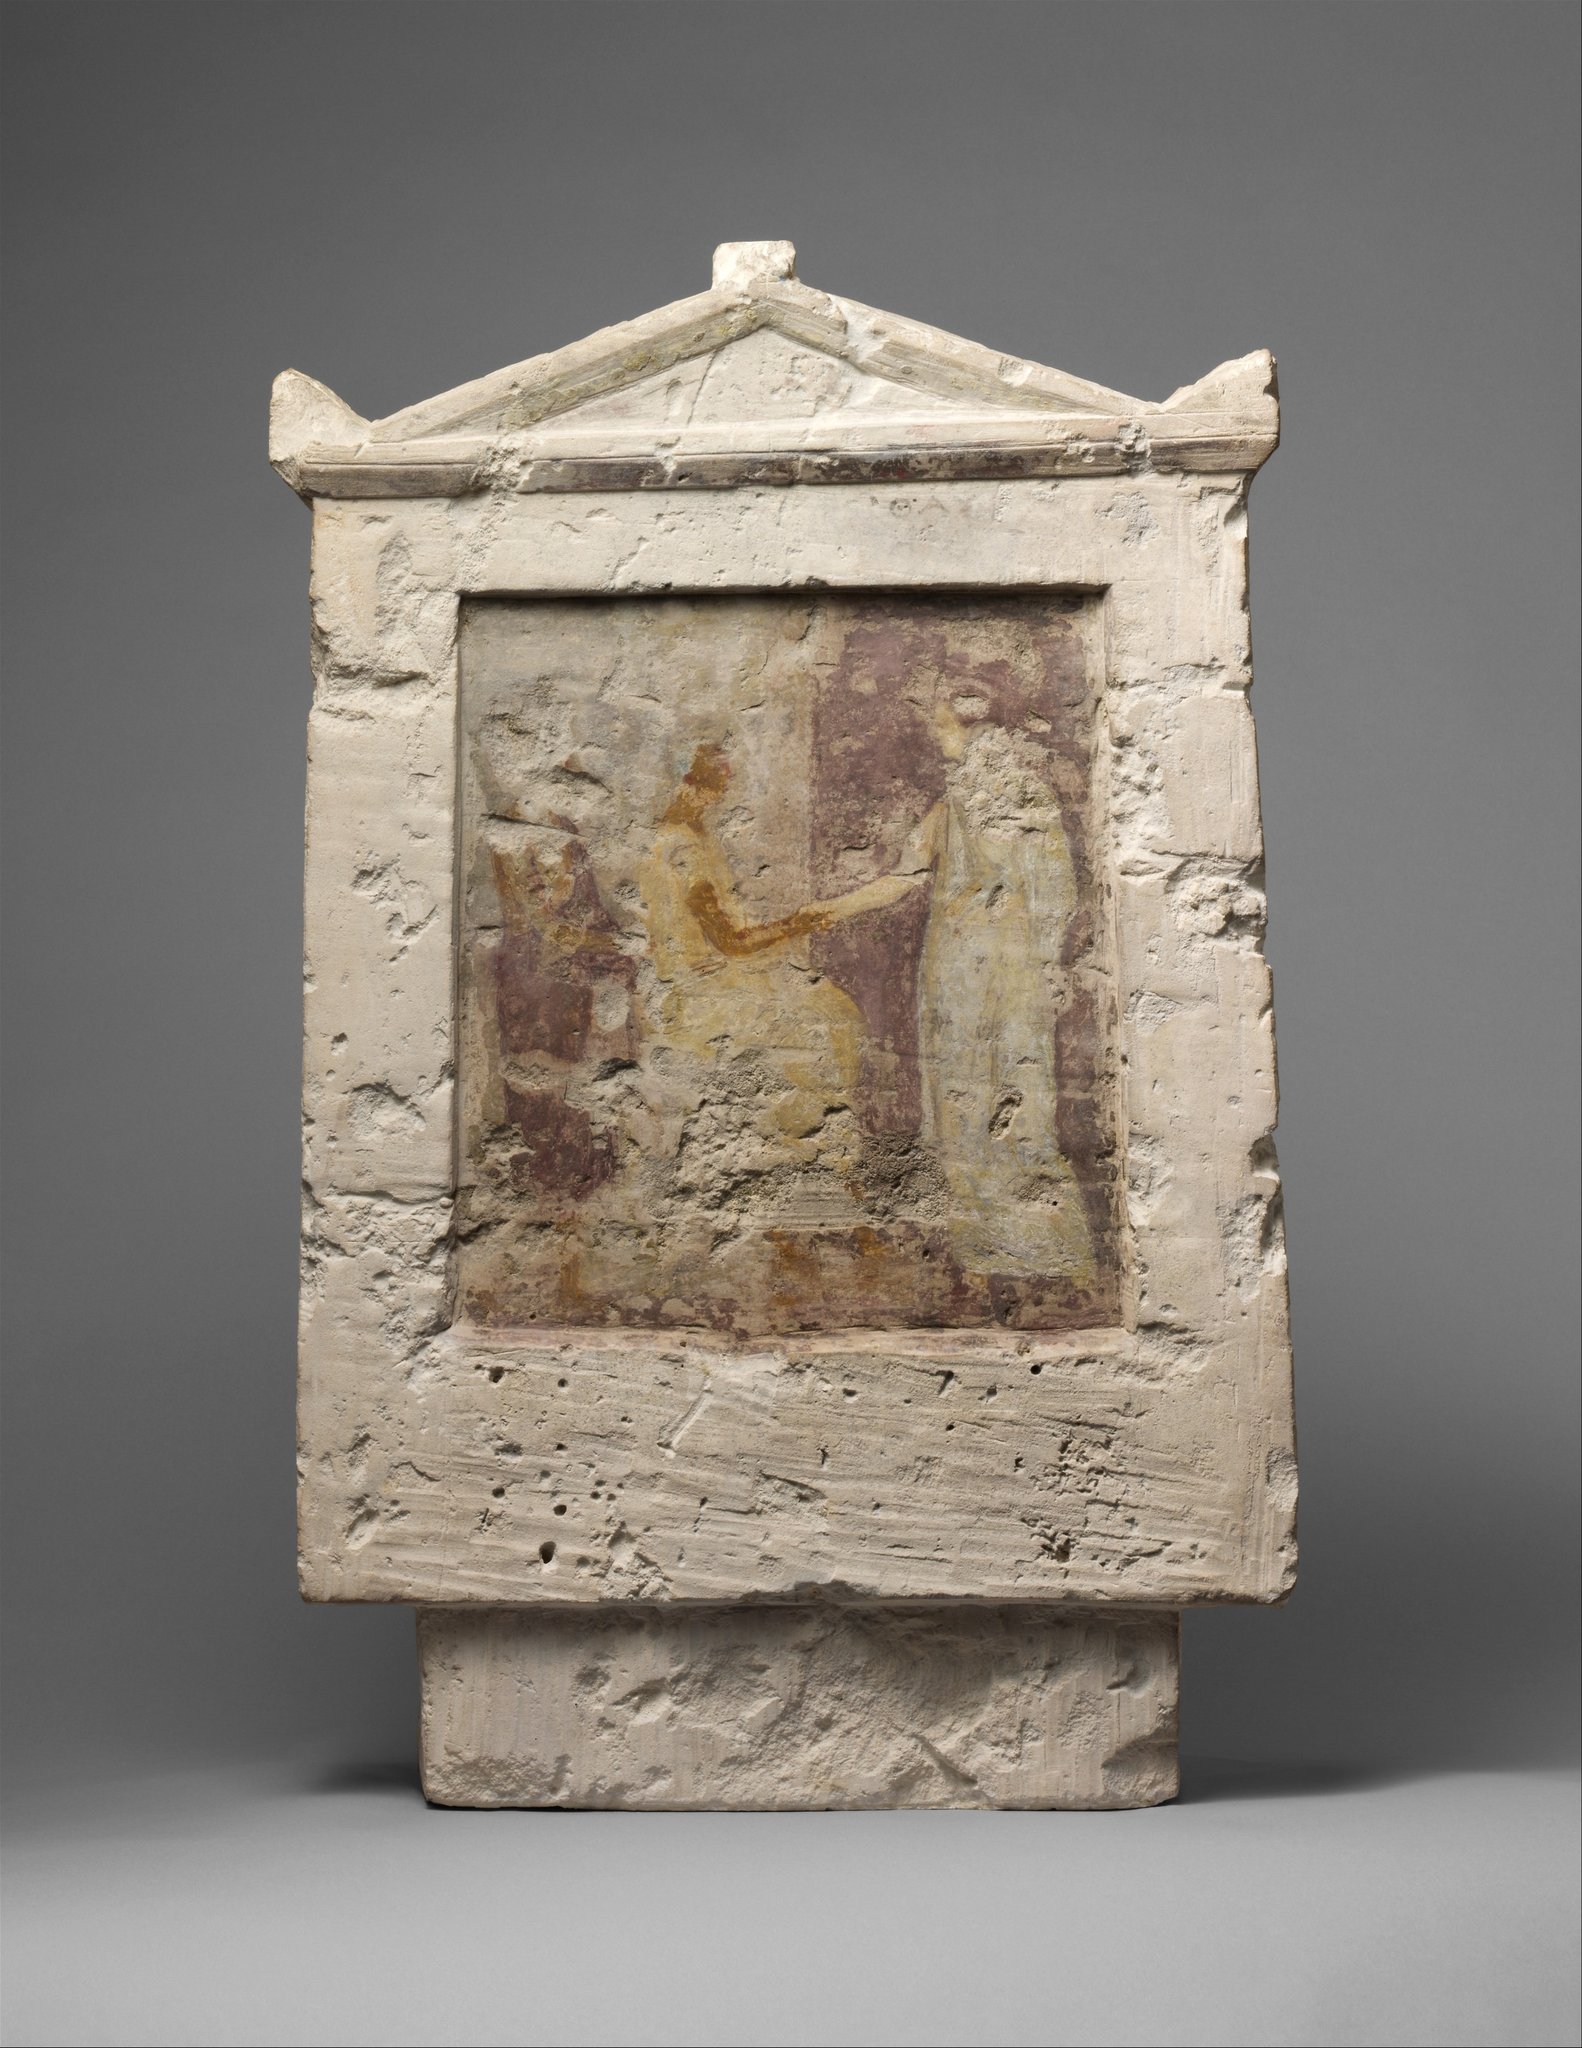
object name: grave stele, painted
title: Painted limestone funerary stele with a seated man and two standing figures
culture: greek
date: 334-268 BCE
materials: limestone, paint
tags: men,women